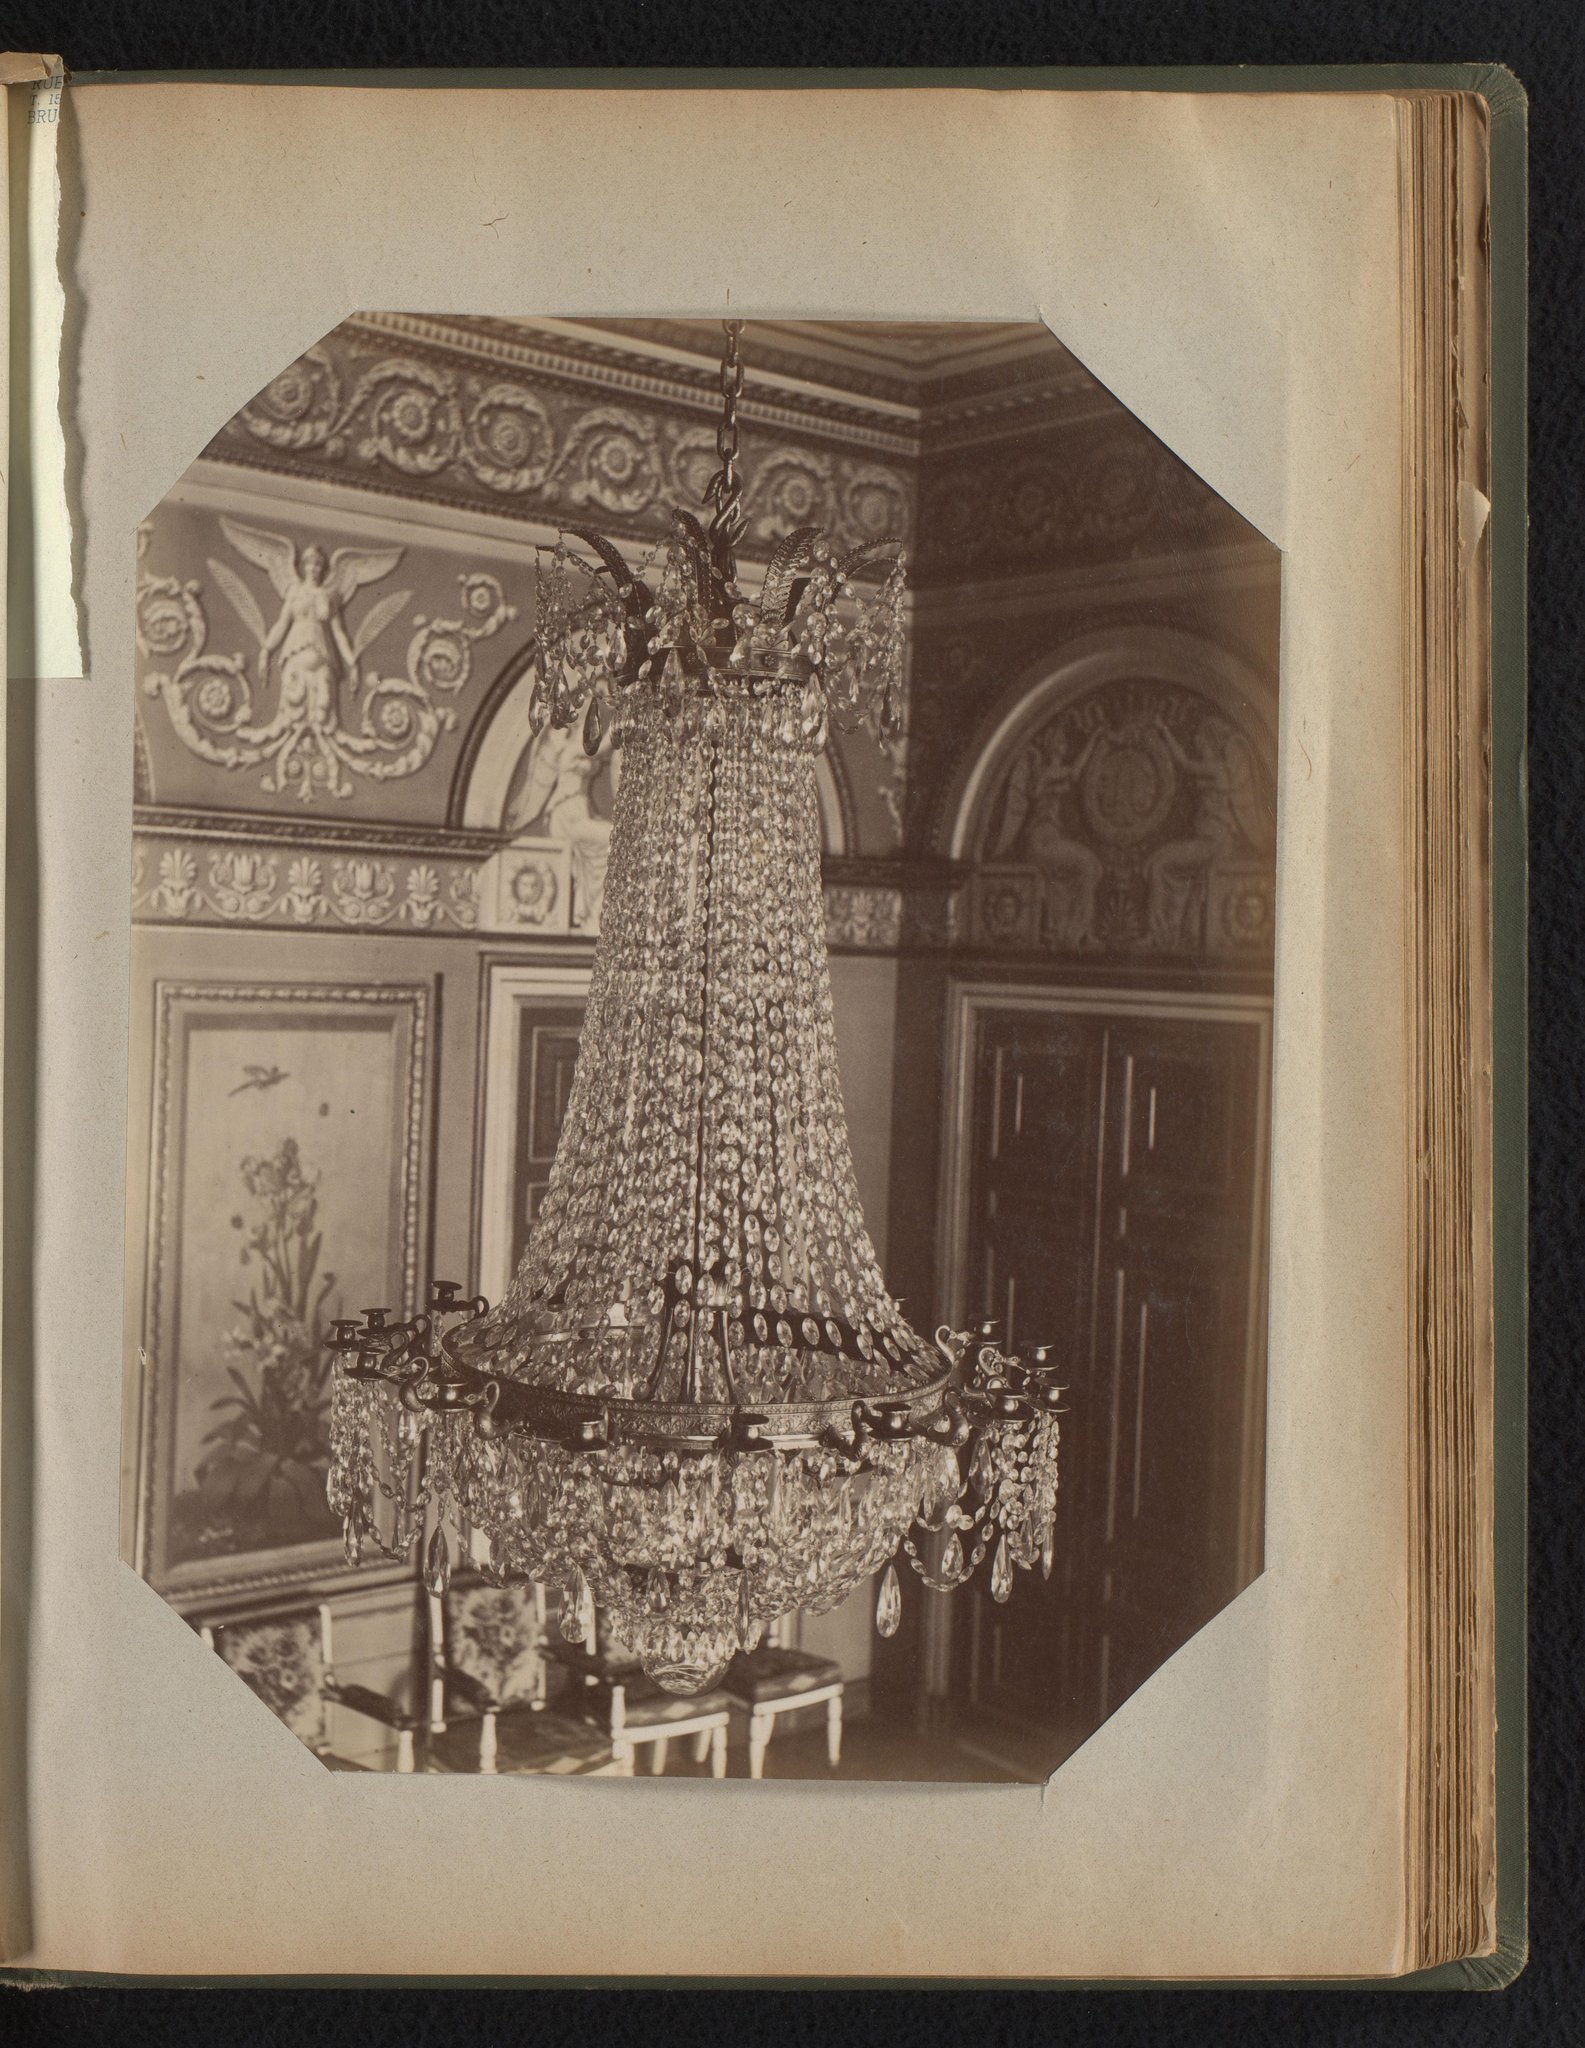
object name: photograph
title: Bronzen kroonluchter behangen met kristallen snoeren en ornamenten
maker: Anonymous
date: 1860-1900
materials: paper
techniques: albumen print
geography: netherlands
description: Onderdeel van een serie met betrekking tot het interieur van het paleis van Versailles met kroonluchters, deuren, portalen en meubelstukken.